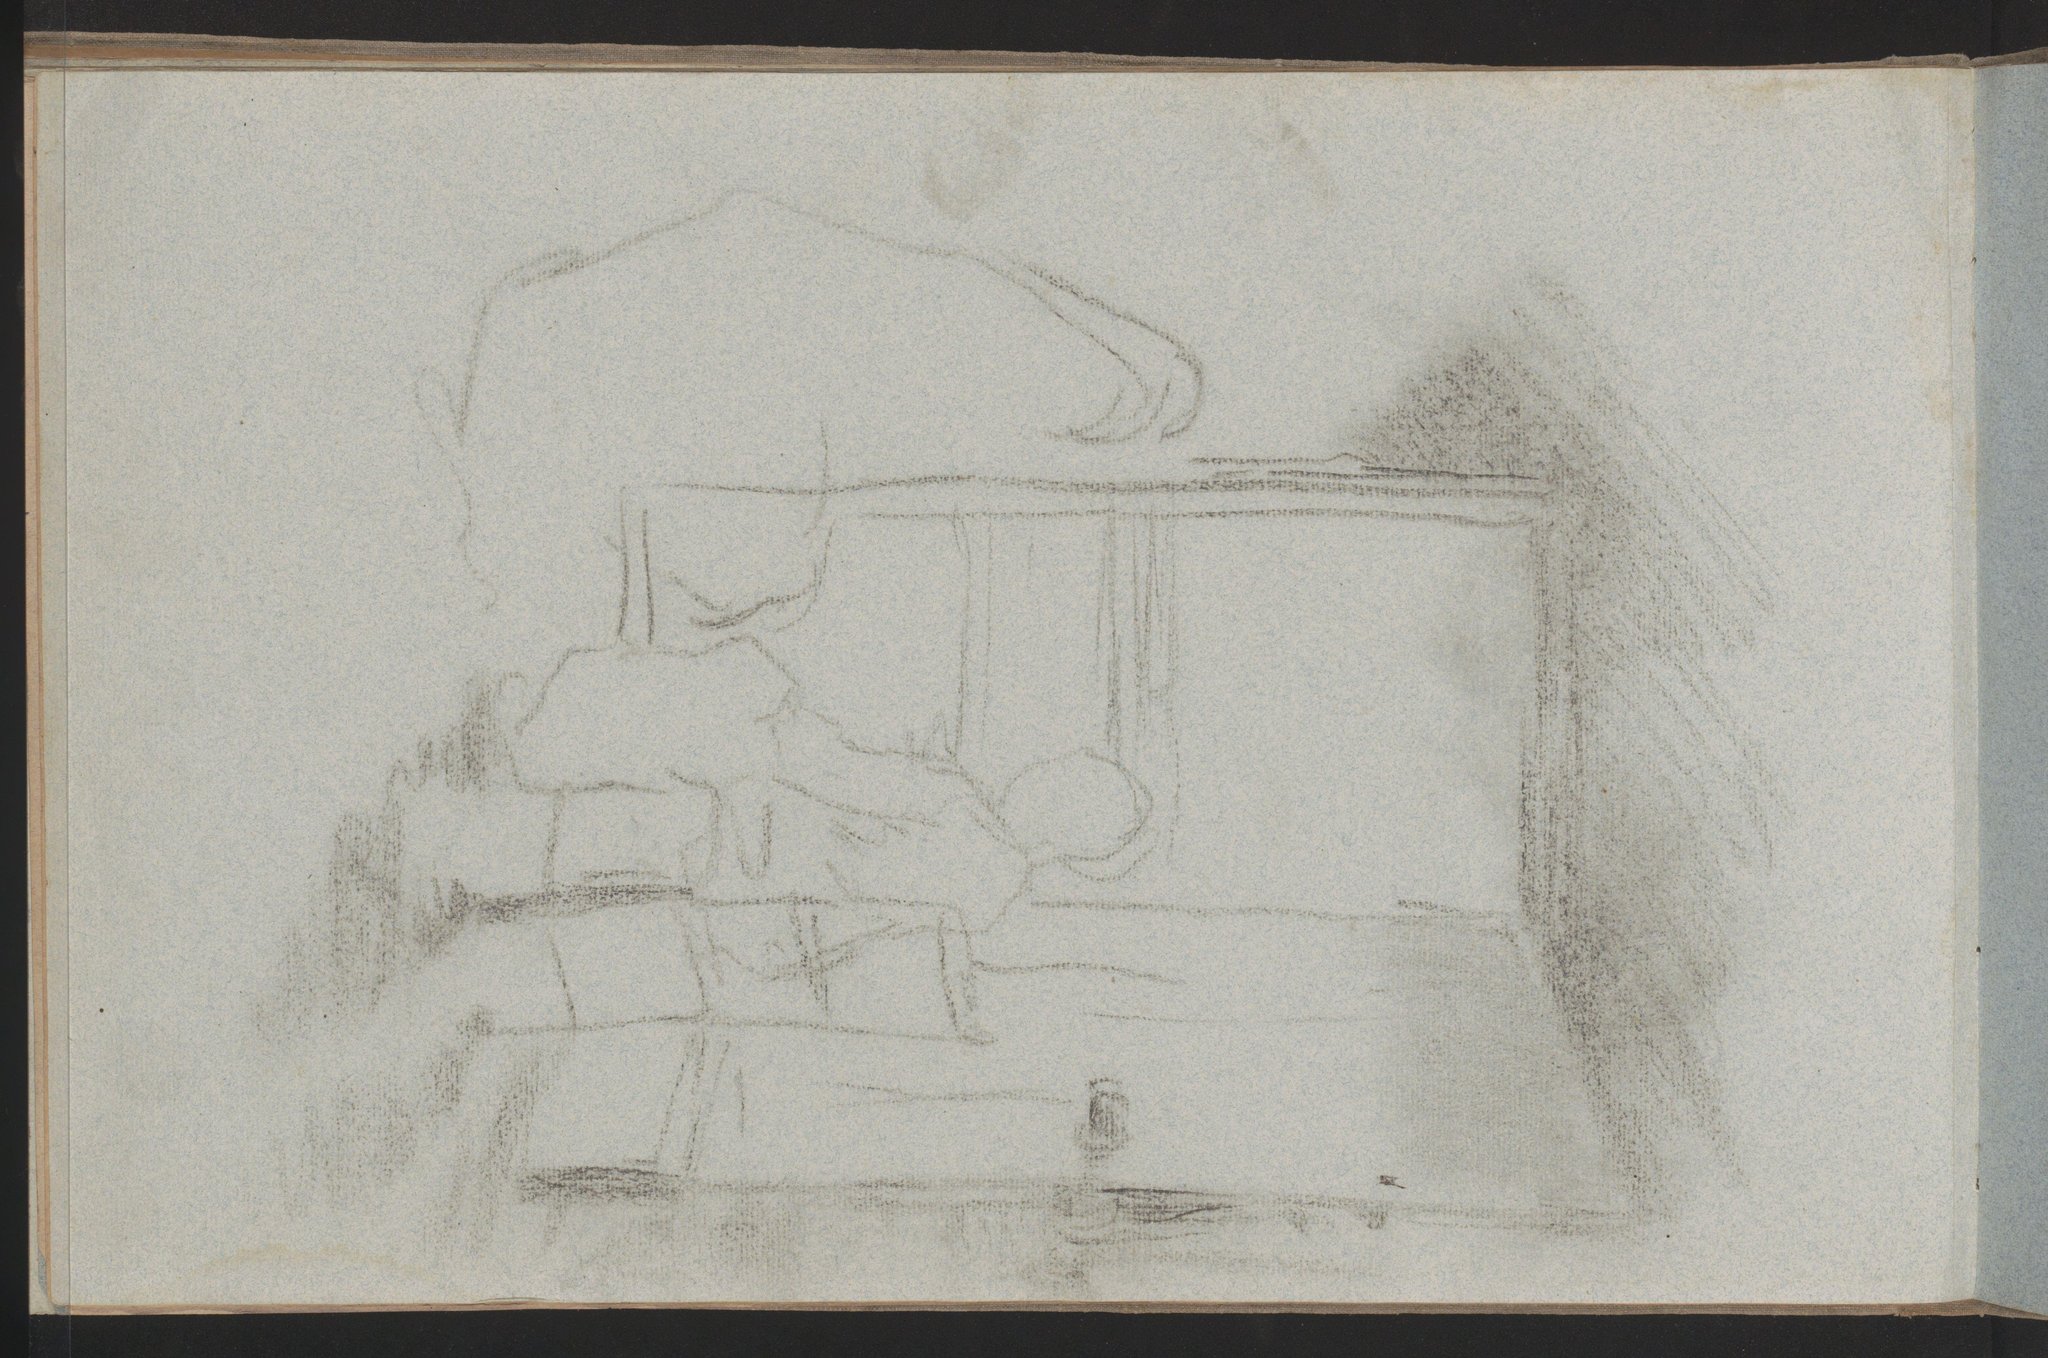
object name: sketchbook leaf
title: Interieur met een vrouw zittend bij een deuropening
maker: albert neuhuys (1844-1914)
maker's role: draughtsman, painter, print maker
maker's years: 1844-1914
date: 1854-1914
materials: charcoal, paper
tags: sitting figure, open door, interior of the house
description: Door de open deur is een vlak landschap te zien. Blad 45 verso uit een schetsboek met 51 bladen.